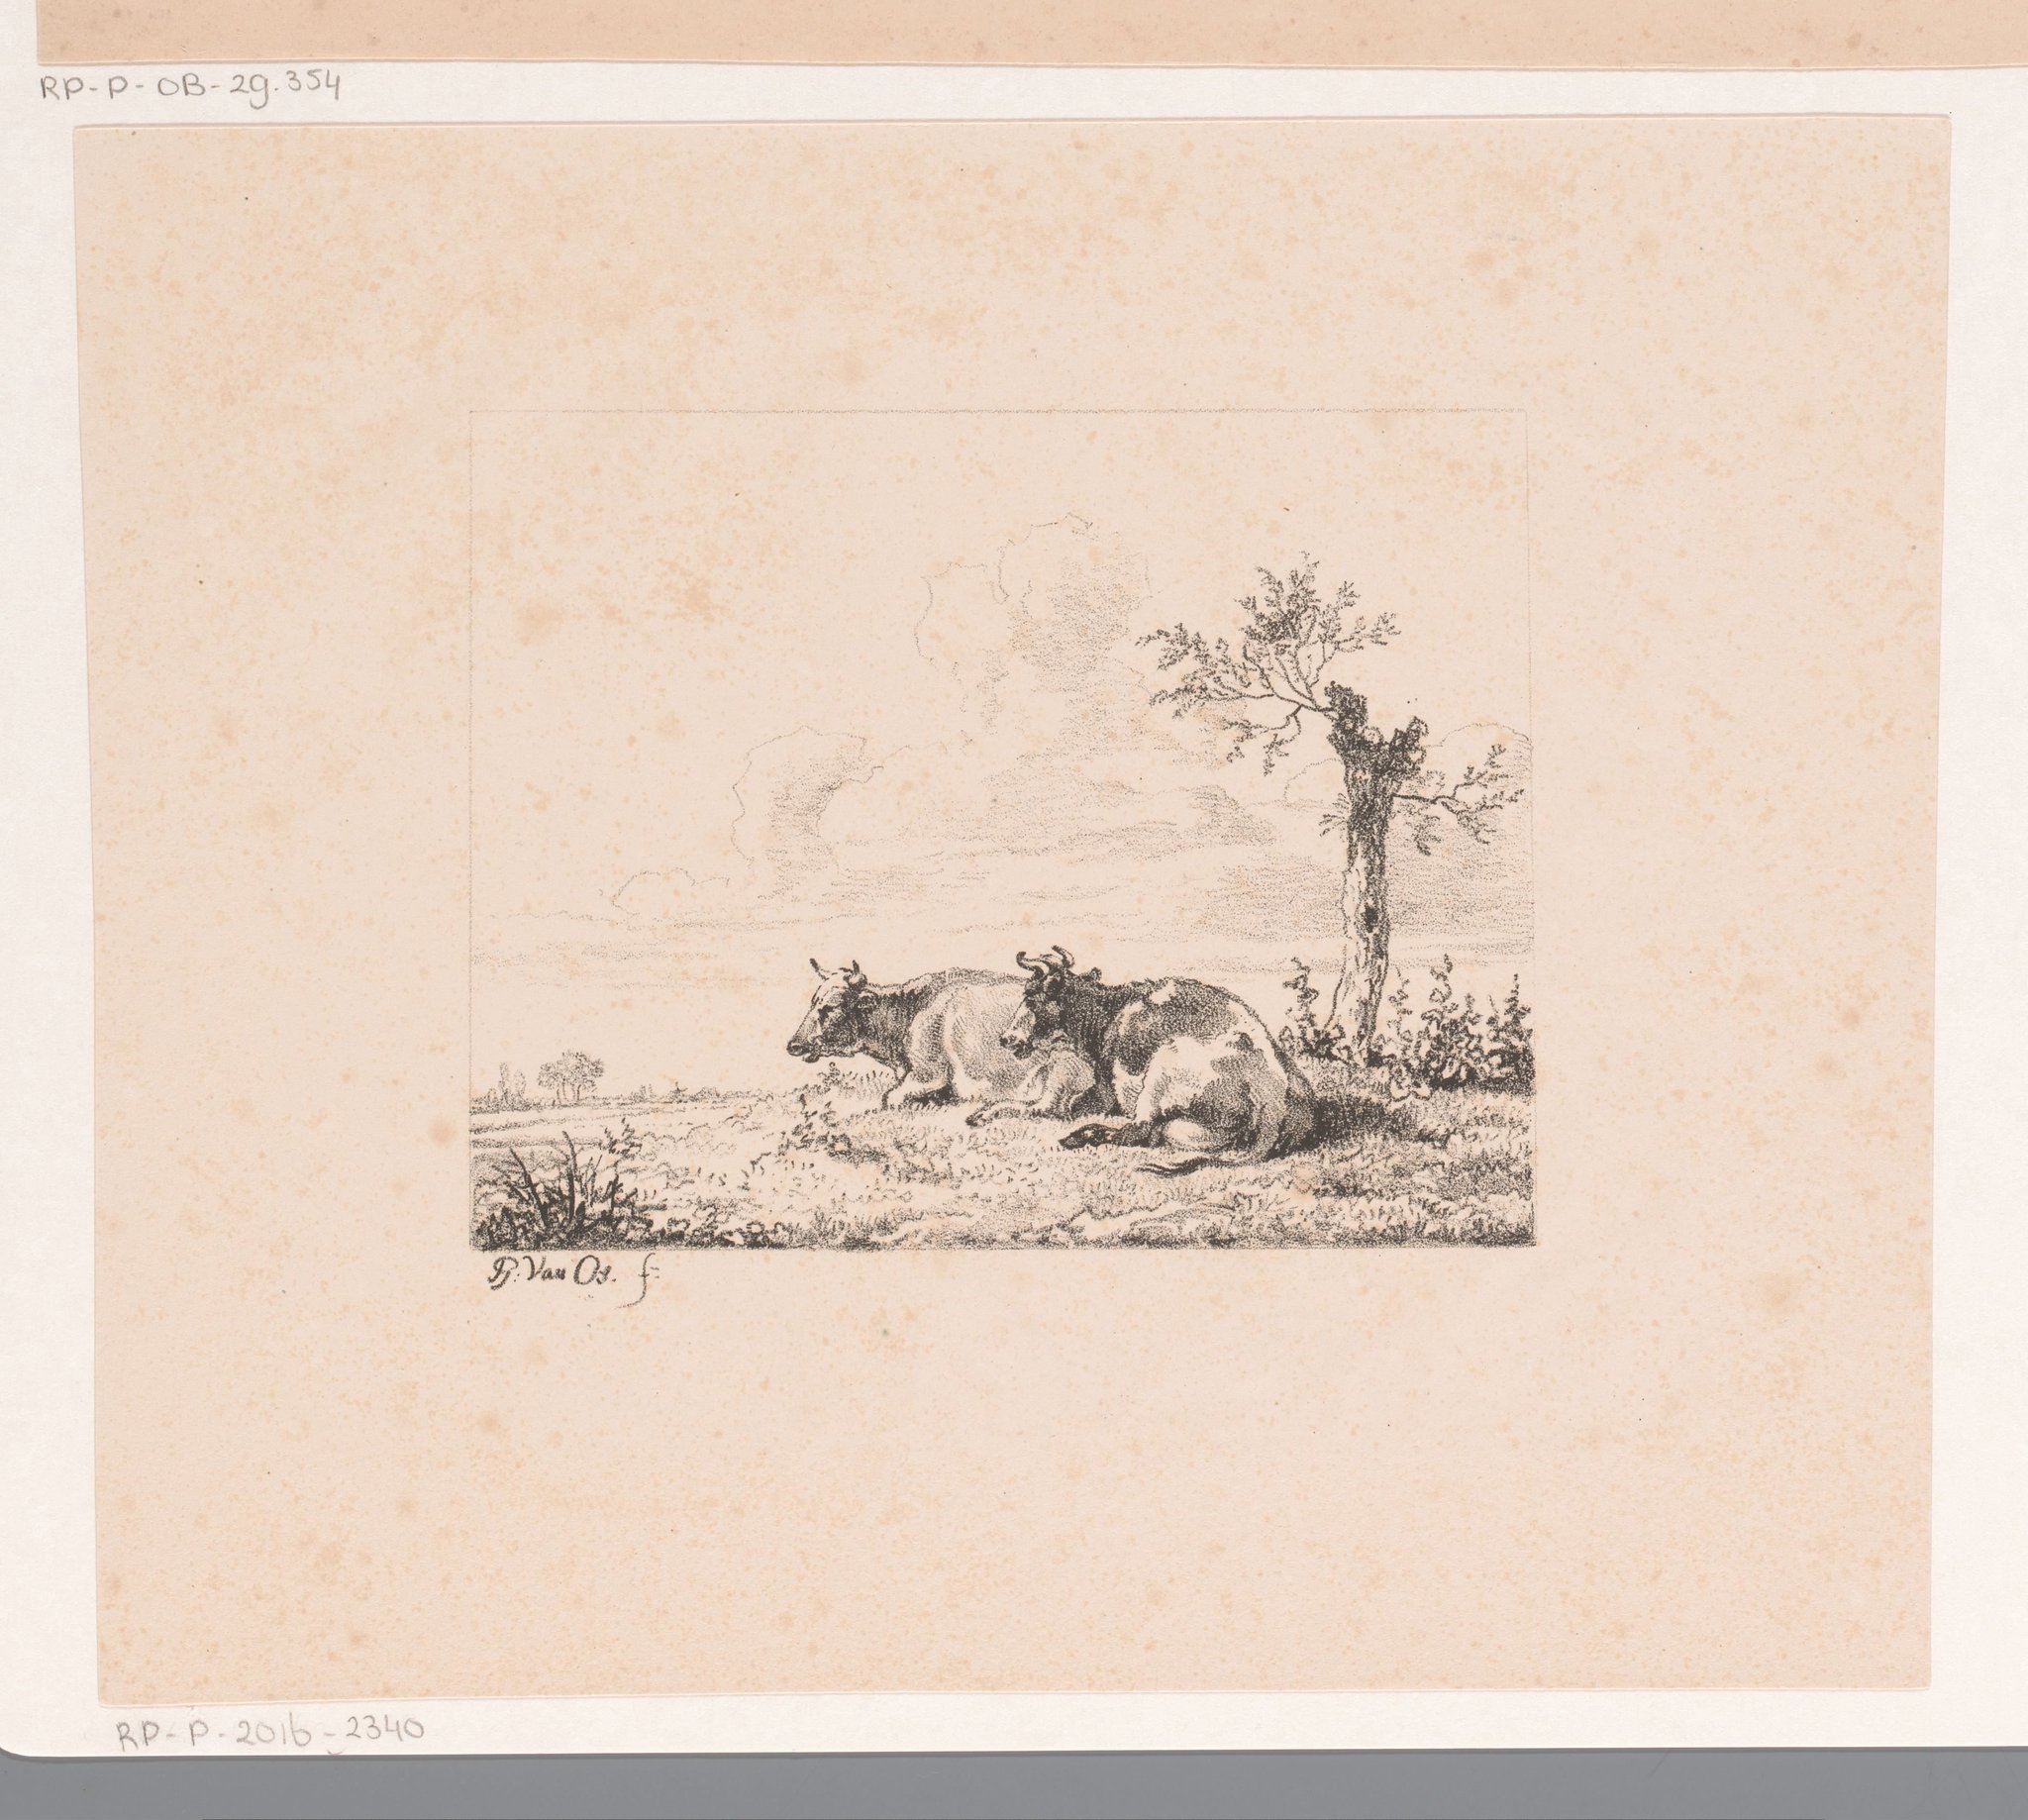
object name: print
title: Twee liggende koeien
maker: pieter gerardus van os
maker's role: draughtsman, painter, print maker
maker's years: 1776-1839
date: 1809-1850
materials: paper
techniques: lithograph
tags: cow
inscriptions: collector's mark: Lugt 2228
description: De koeien liggen in een weiland bij een boom.